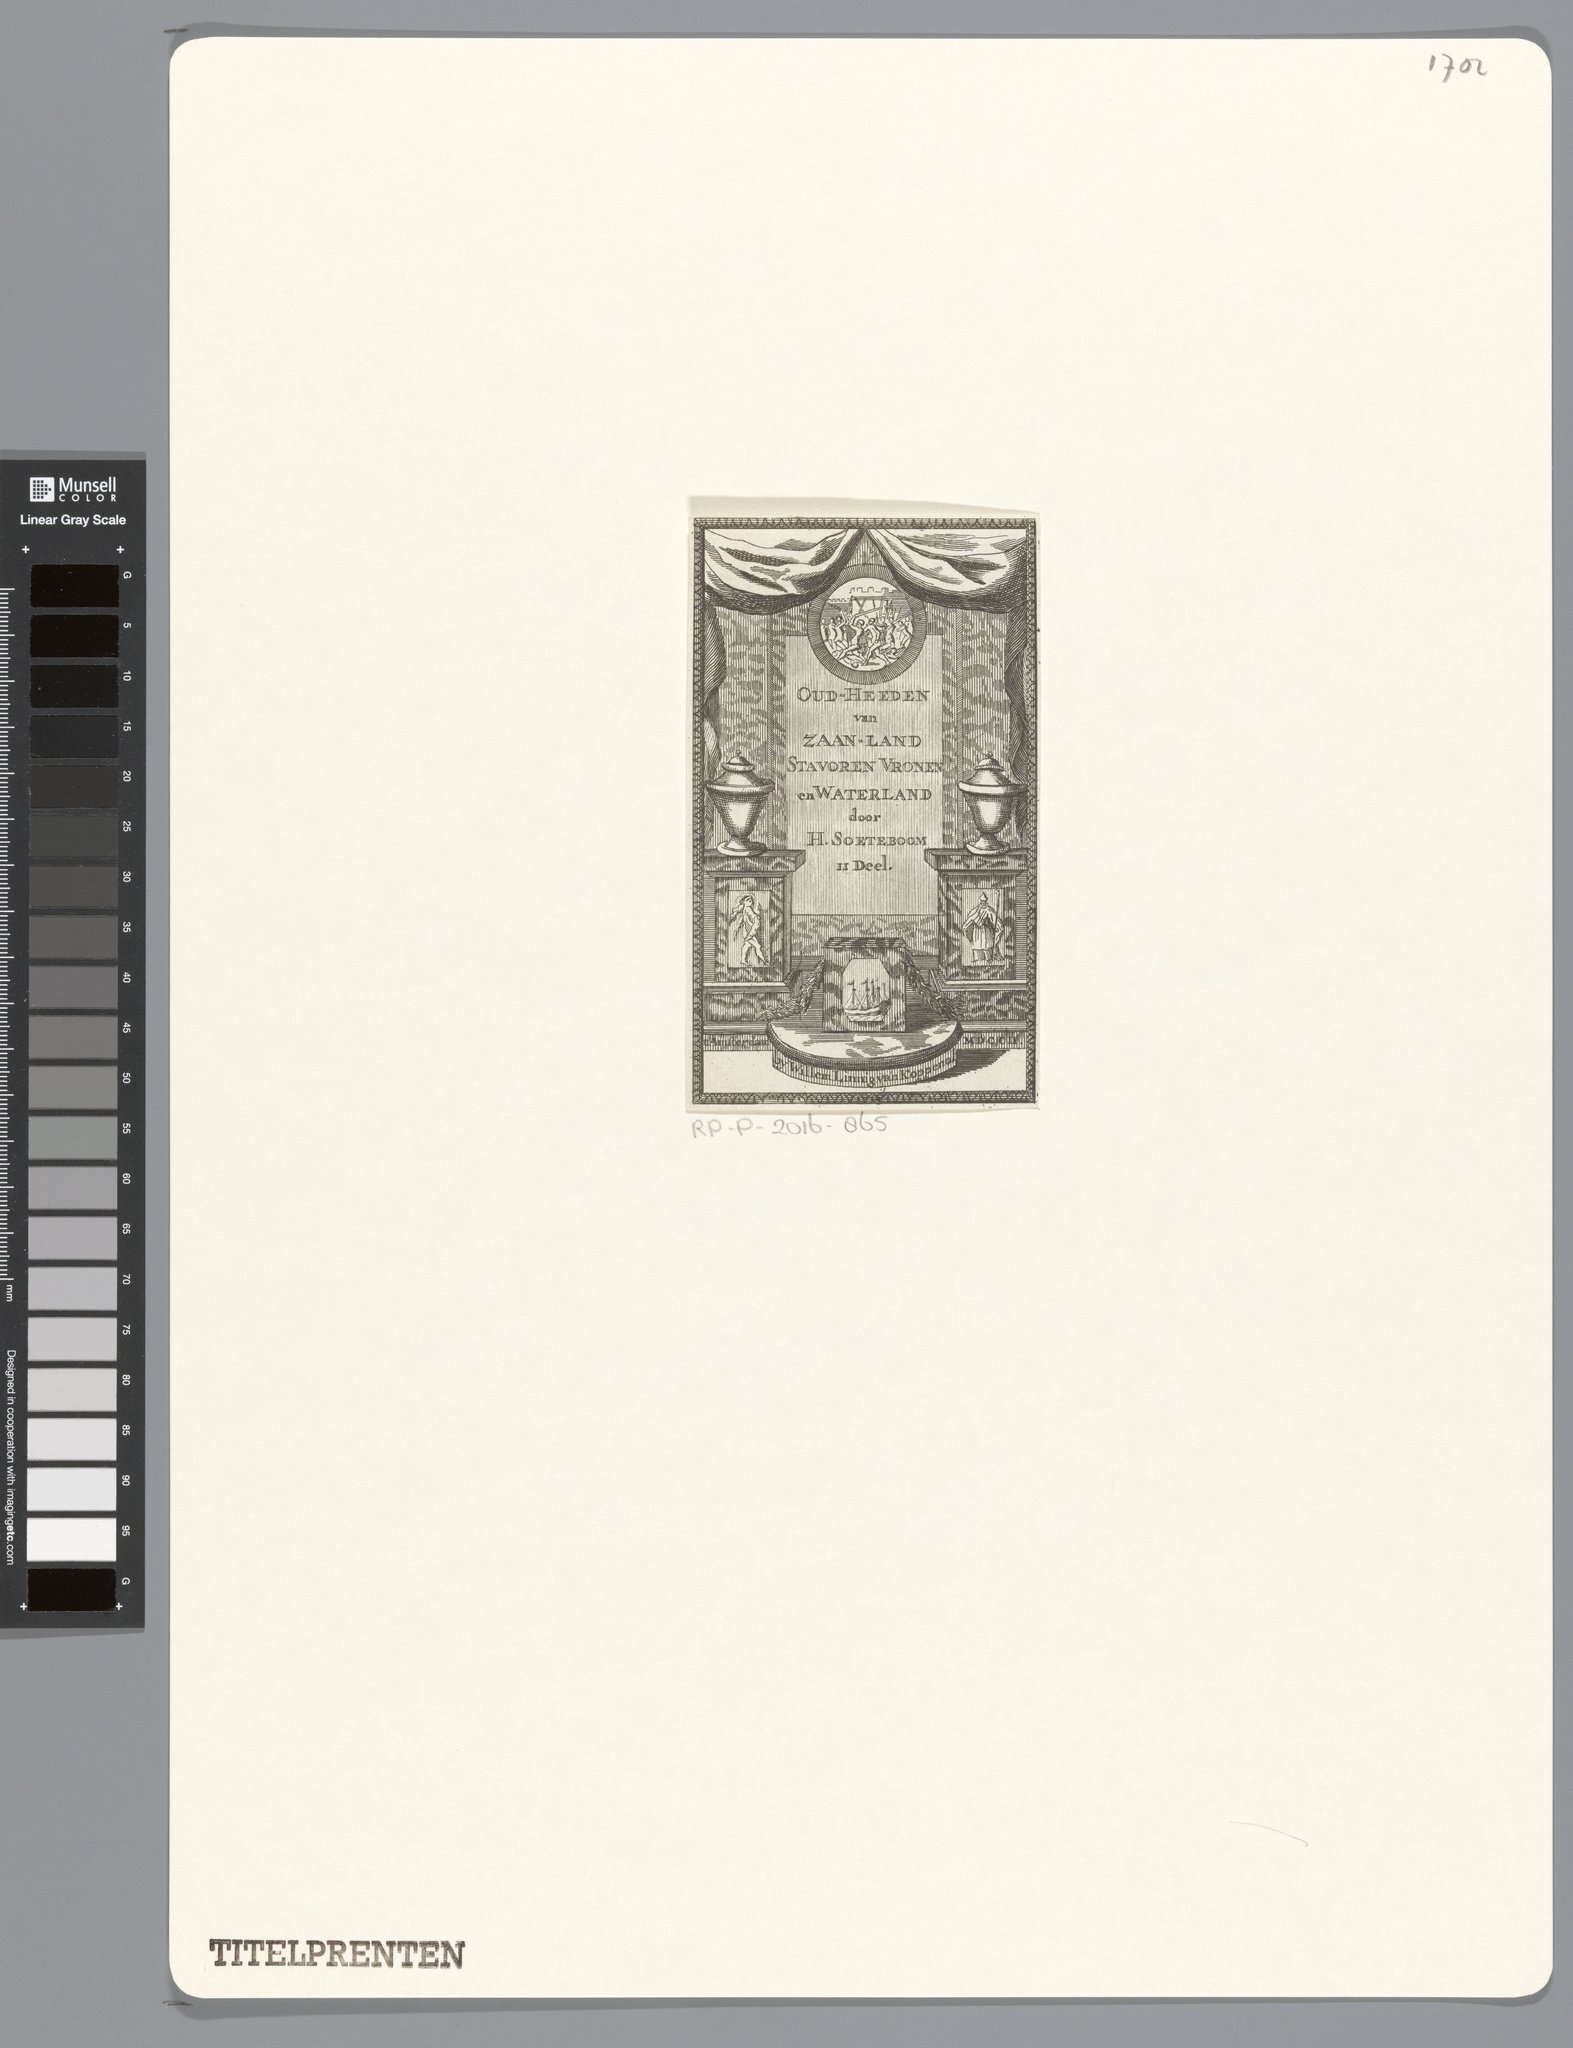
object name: titelblad, titelpagina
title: Titelpagina voor: Hendrik Soeteboom, Oud-Heeden van Zaan-land Stavoren Vronen en Waterland, 1702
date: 1702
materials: paper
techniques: etching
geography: amsterdam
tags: vase ~ ornament, pedestal of a piece of sculpture (perhaps in the form of a herm)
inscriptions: collector's mark: Lugt 2228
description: Tablet met boektitel en een medaillon met een veldslag. Daarvoor twee voetstukken met vazen en afbeeldingen van een vrouw en een religieuze. Op de voorgrond een kubus met een schip op een laag voetstuk. Boven het geheel draperieën.